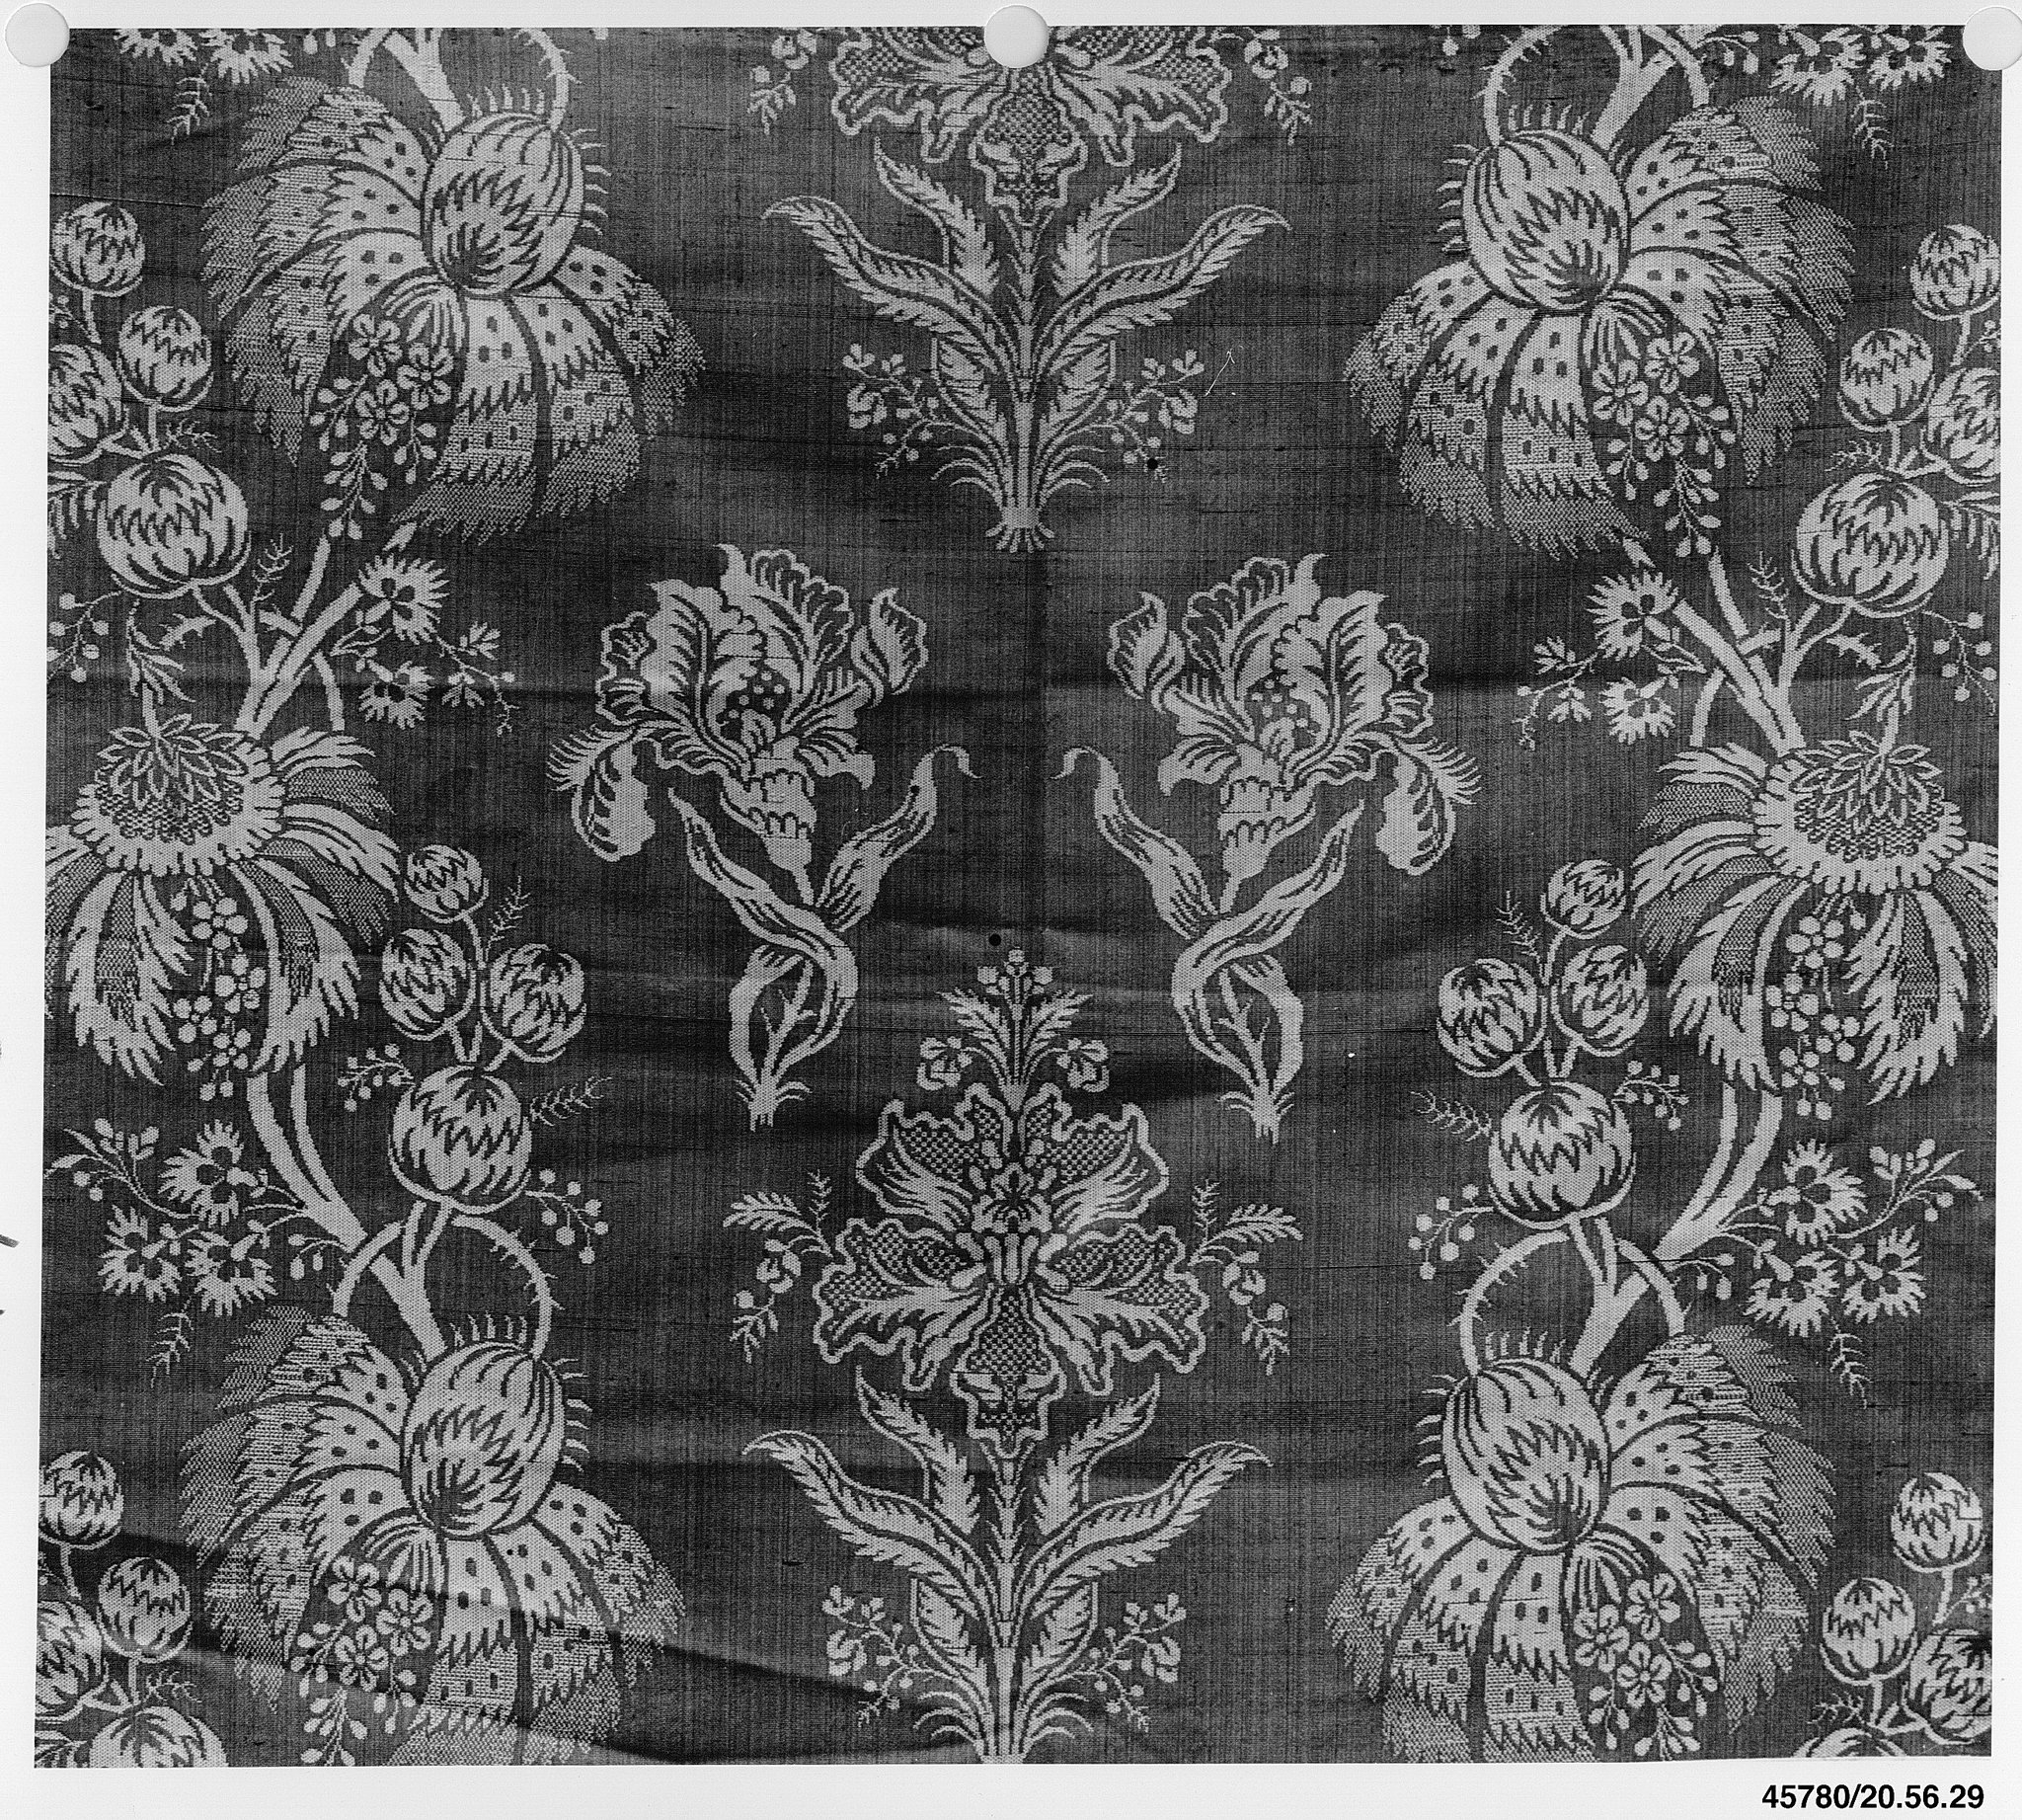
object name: piece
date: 1735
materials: silk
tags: flowers,leaves